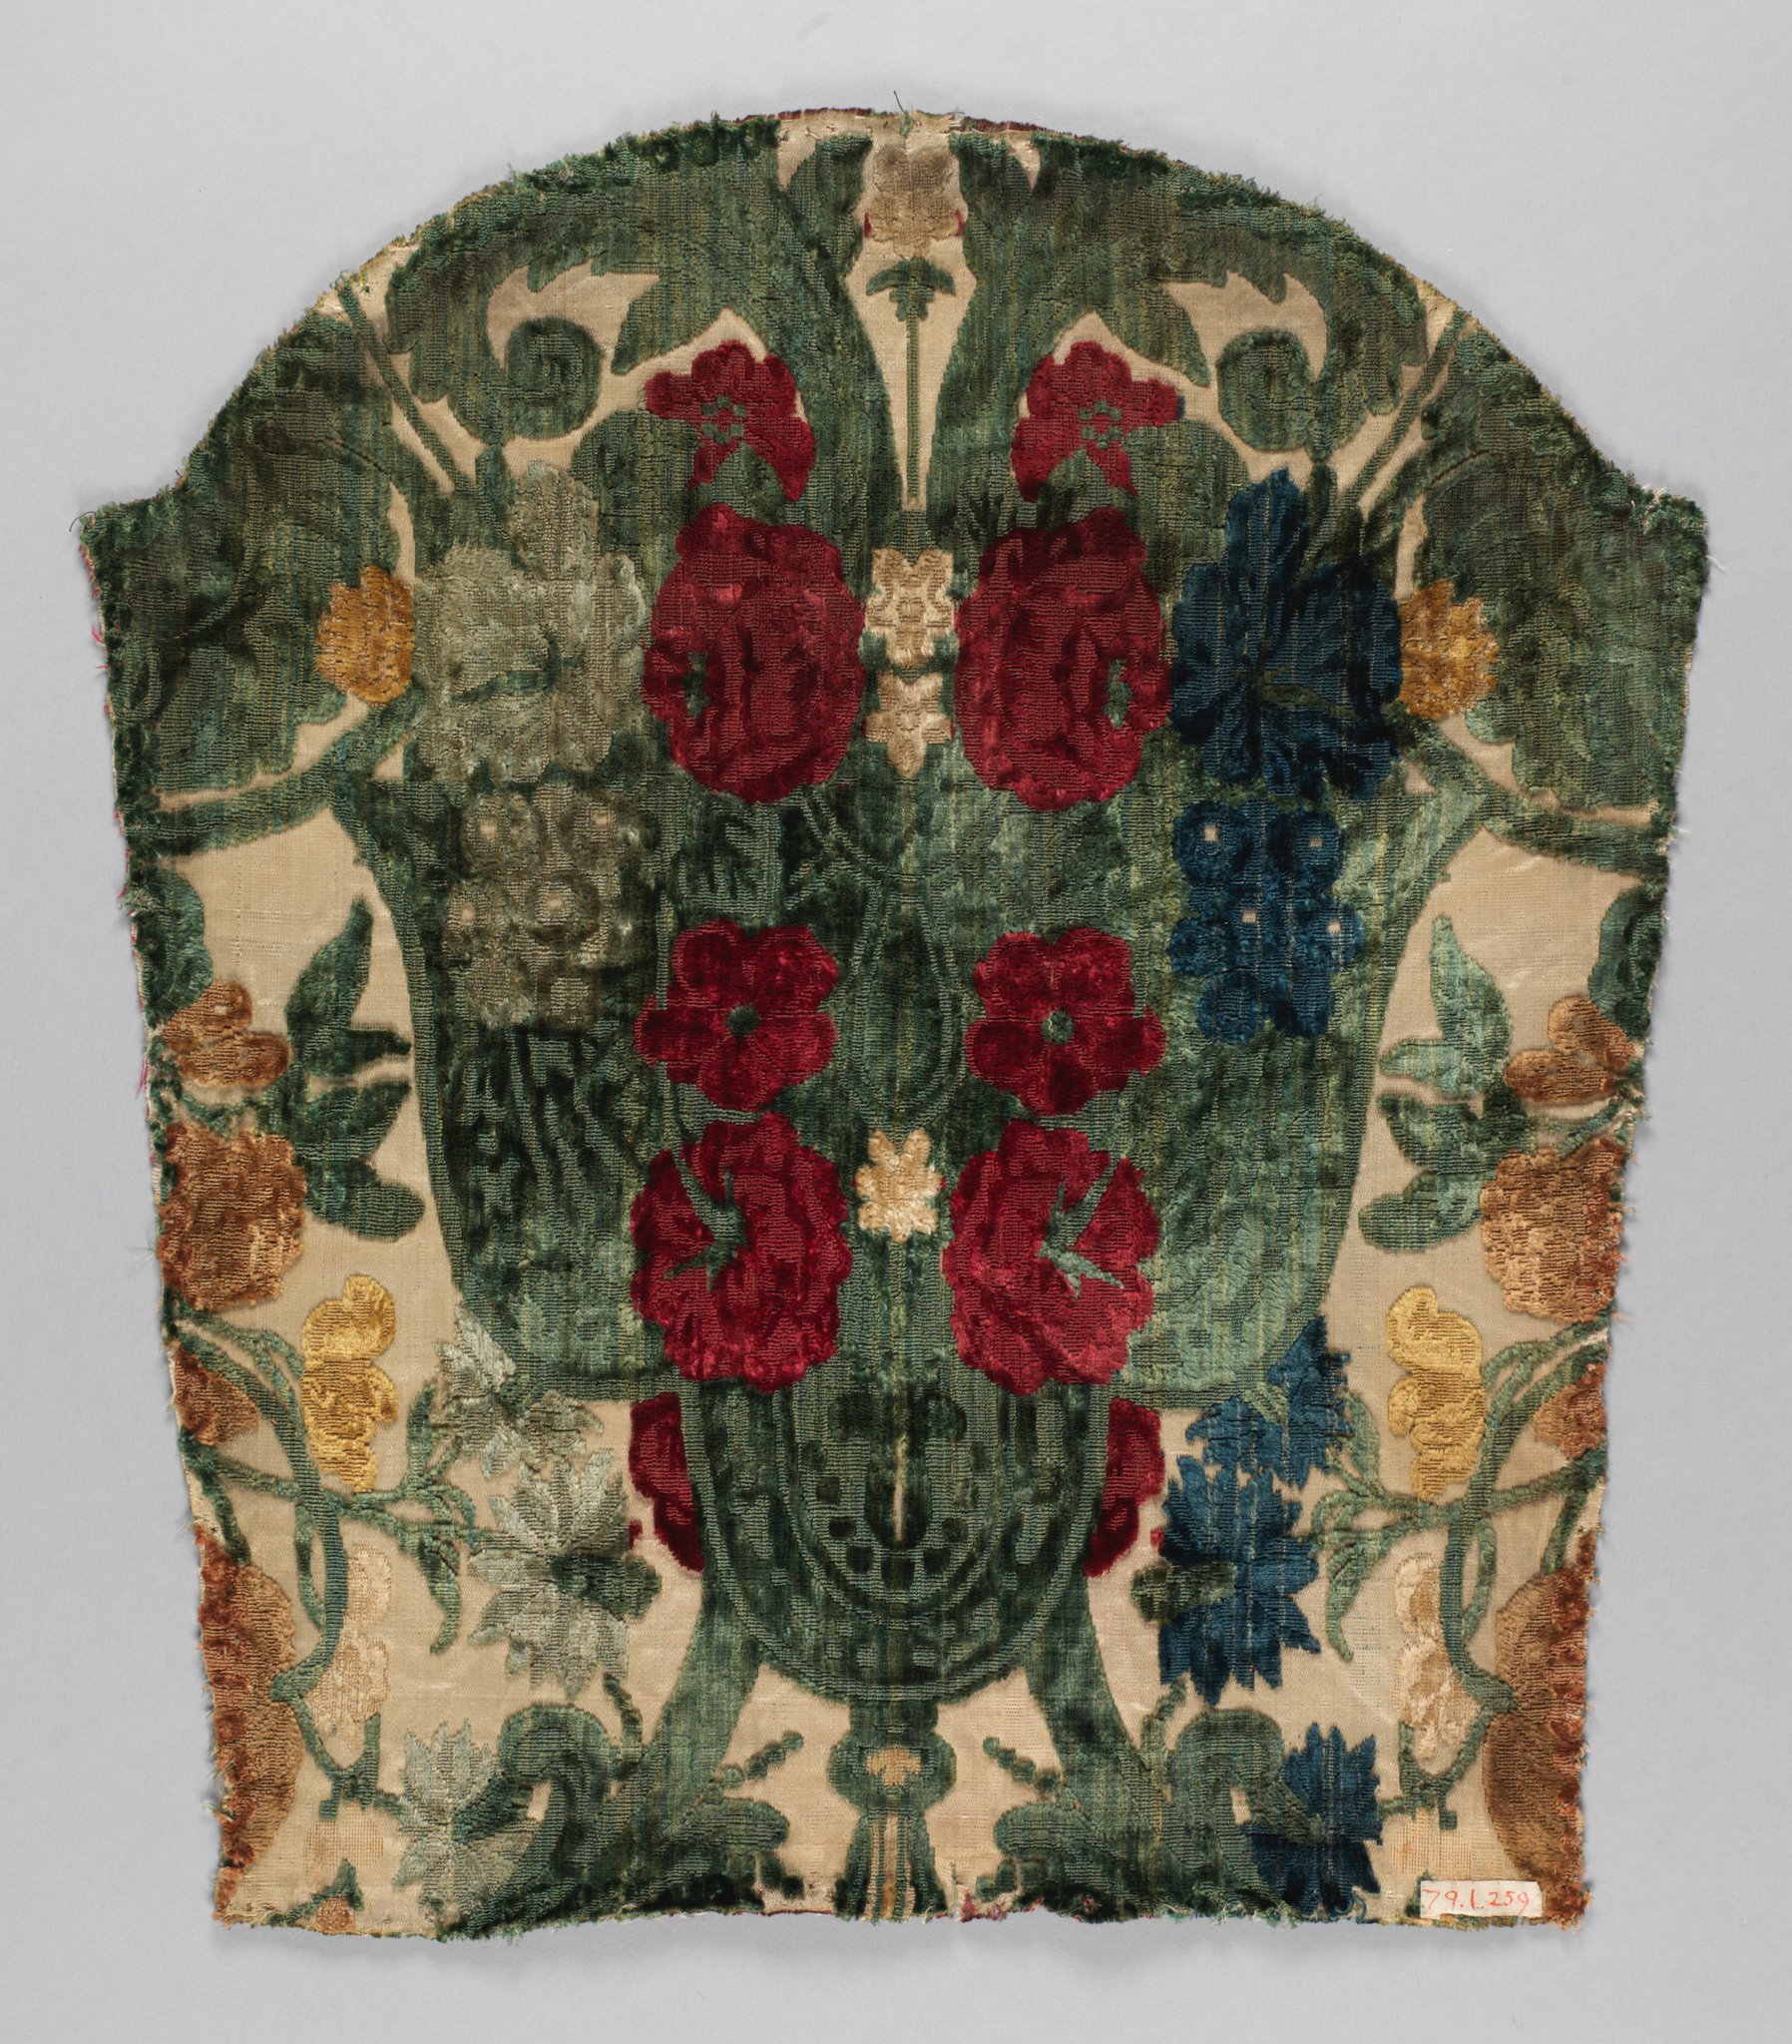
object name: upholstery panel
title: Cut and Uncut Polychrome Voided Satin Velvet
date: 1675-1725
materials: silk